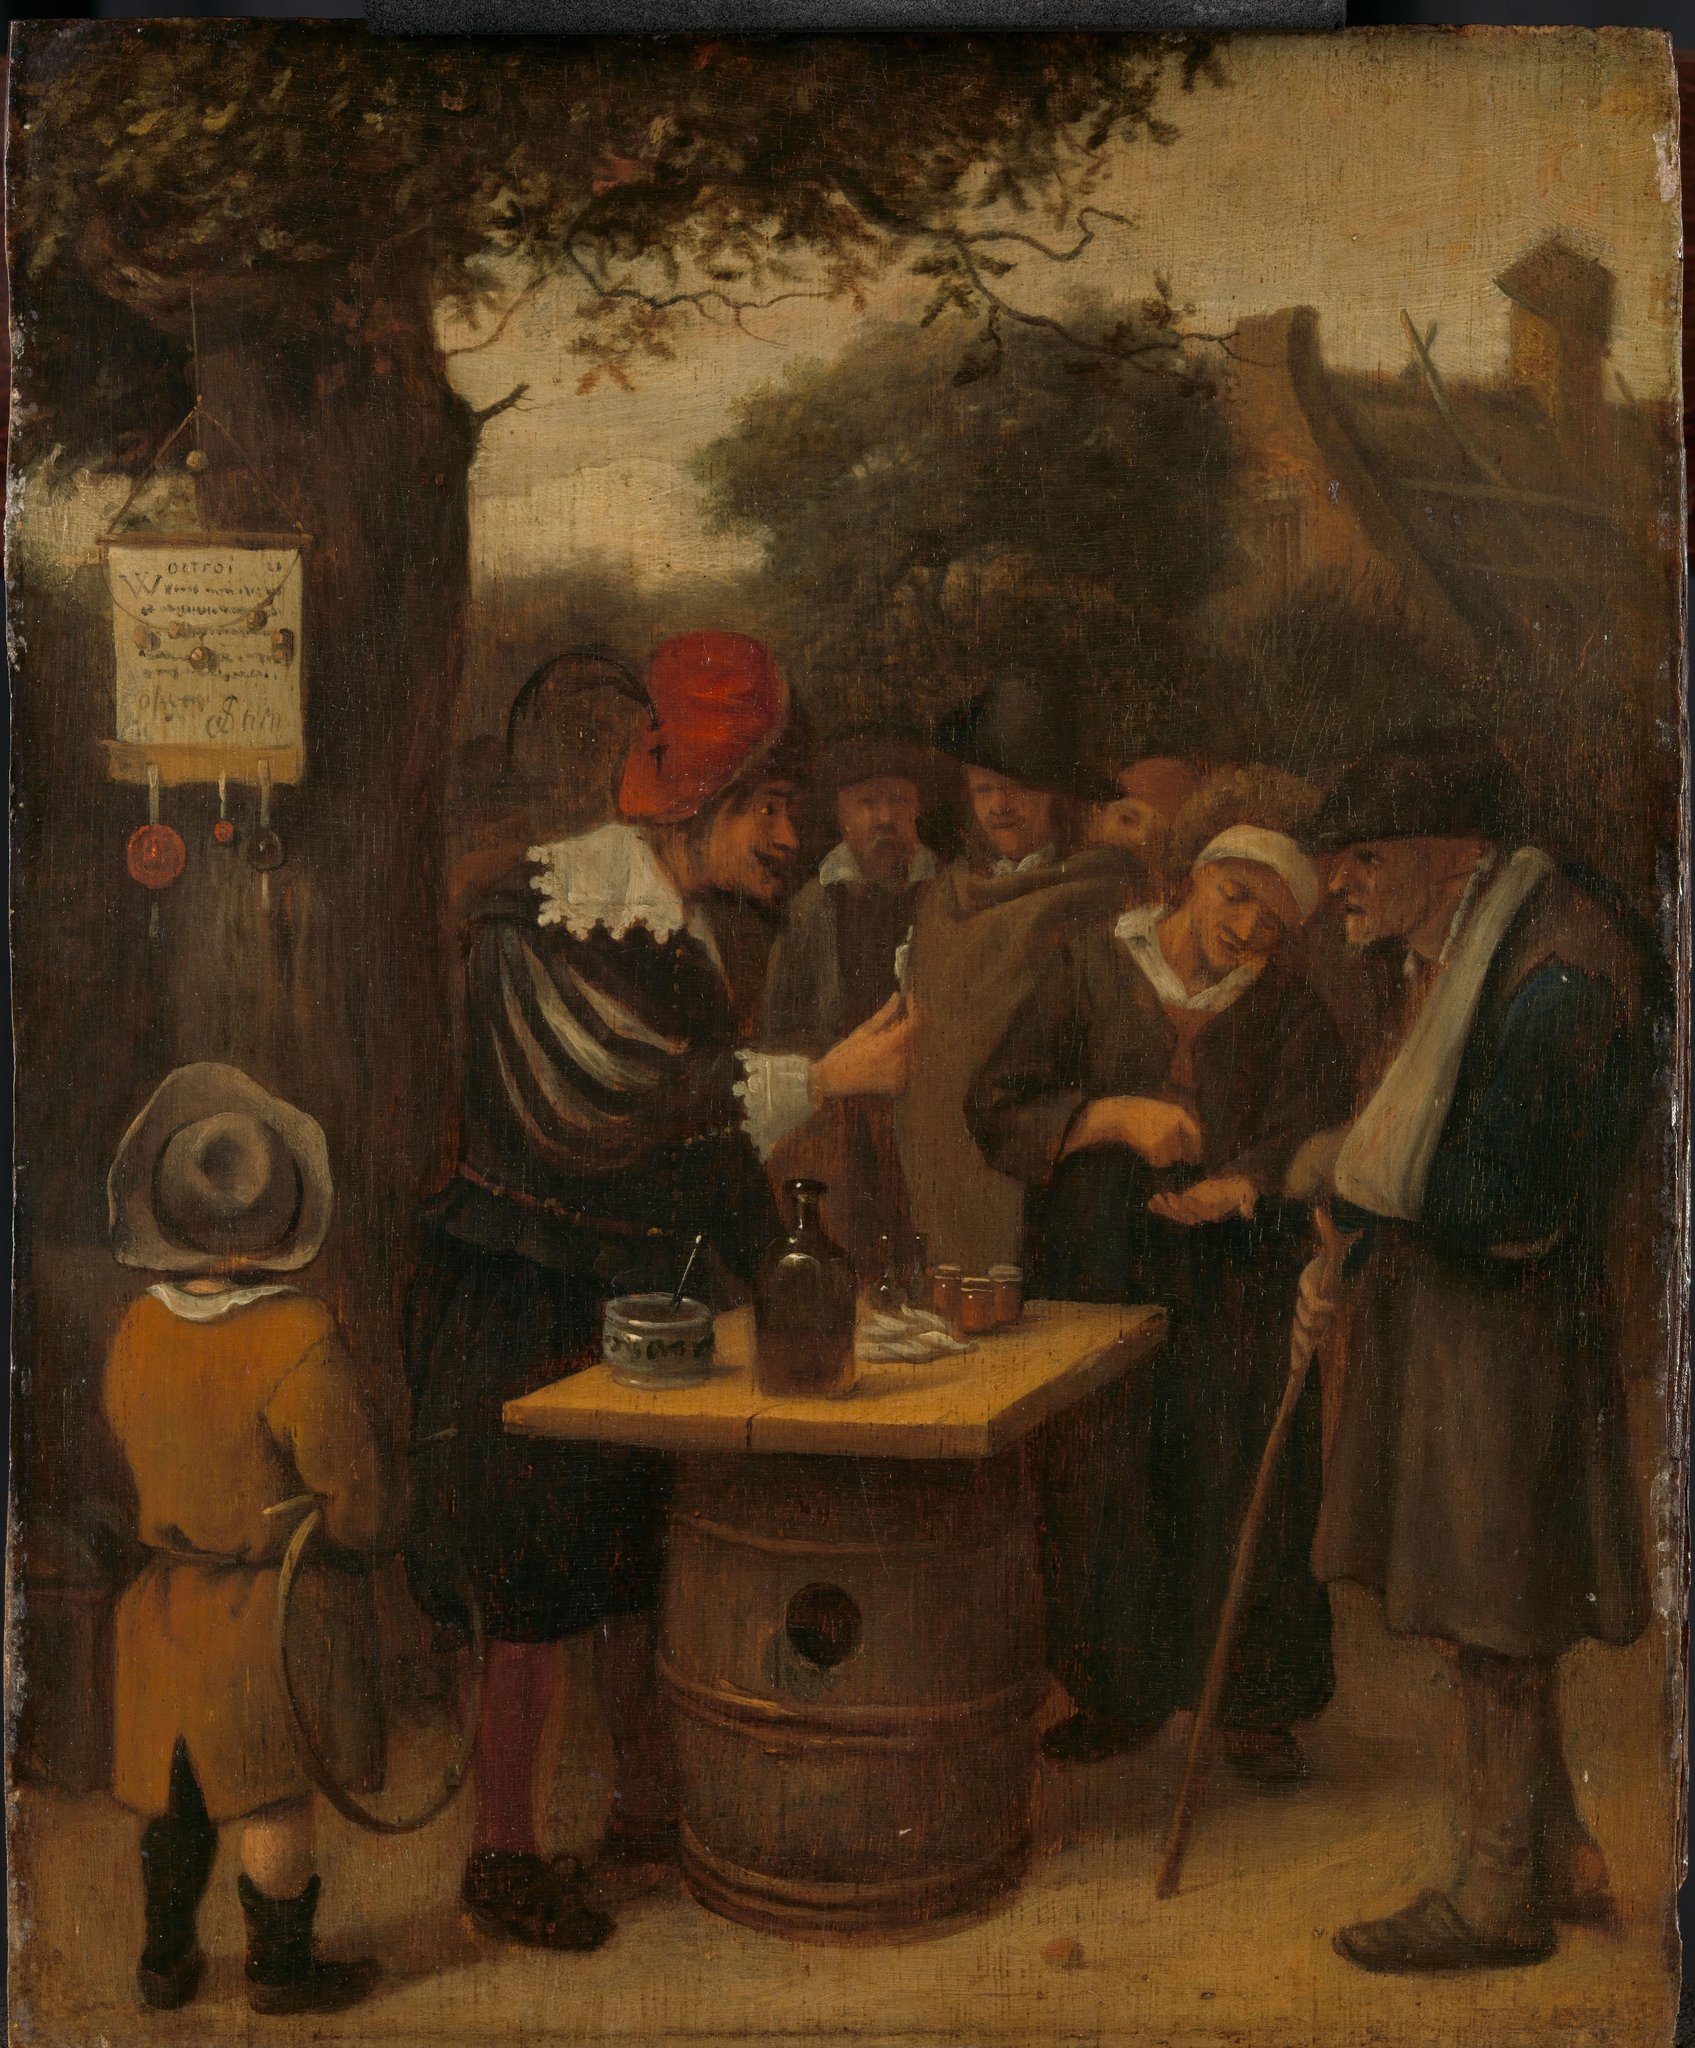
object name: painting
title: The quack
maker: jan havicksz. steen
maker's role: painter, print maker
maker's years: 1625-1679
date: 1650-1679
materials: oil, panel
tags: quack, charlatan, mountebank, 'saltimbanco', seal, stamp, treatment by immobilization, sling, splint, plaster, etc., scroll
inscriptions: signature: ‘JSteen’, inscription: ‘Octroi [...]’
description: Een kwakzalver prijst staande achter een ton zijn geneesmiddelen aan. Tussen het publiek telt een vrouw geldstukken in haar hand, voor de ton staat een oude man met een gebroken arm. Aan een boom hangt een document met zegels.